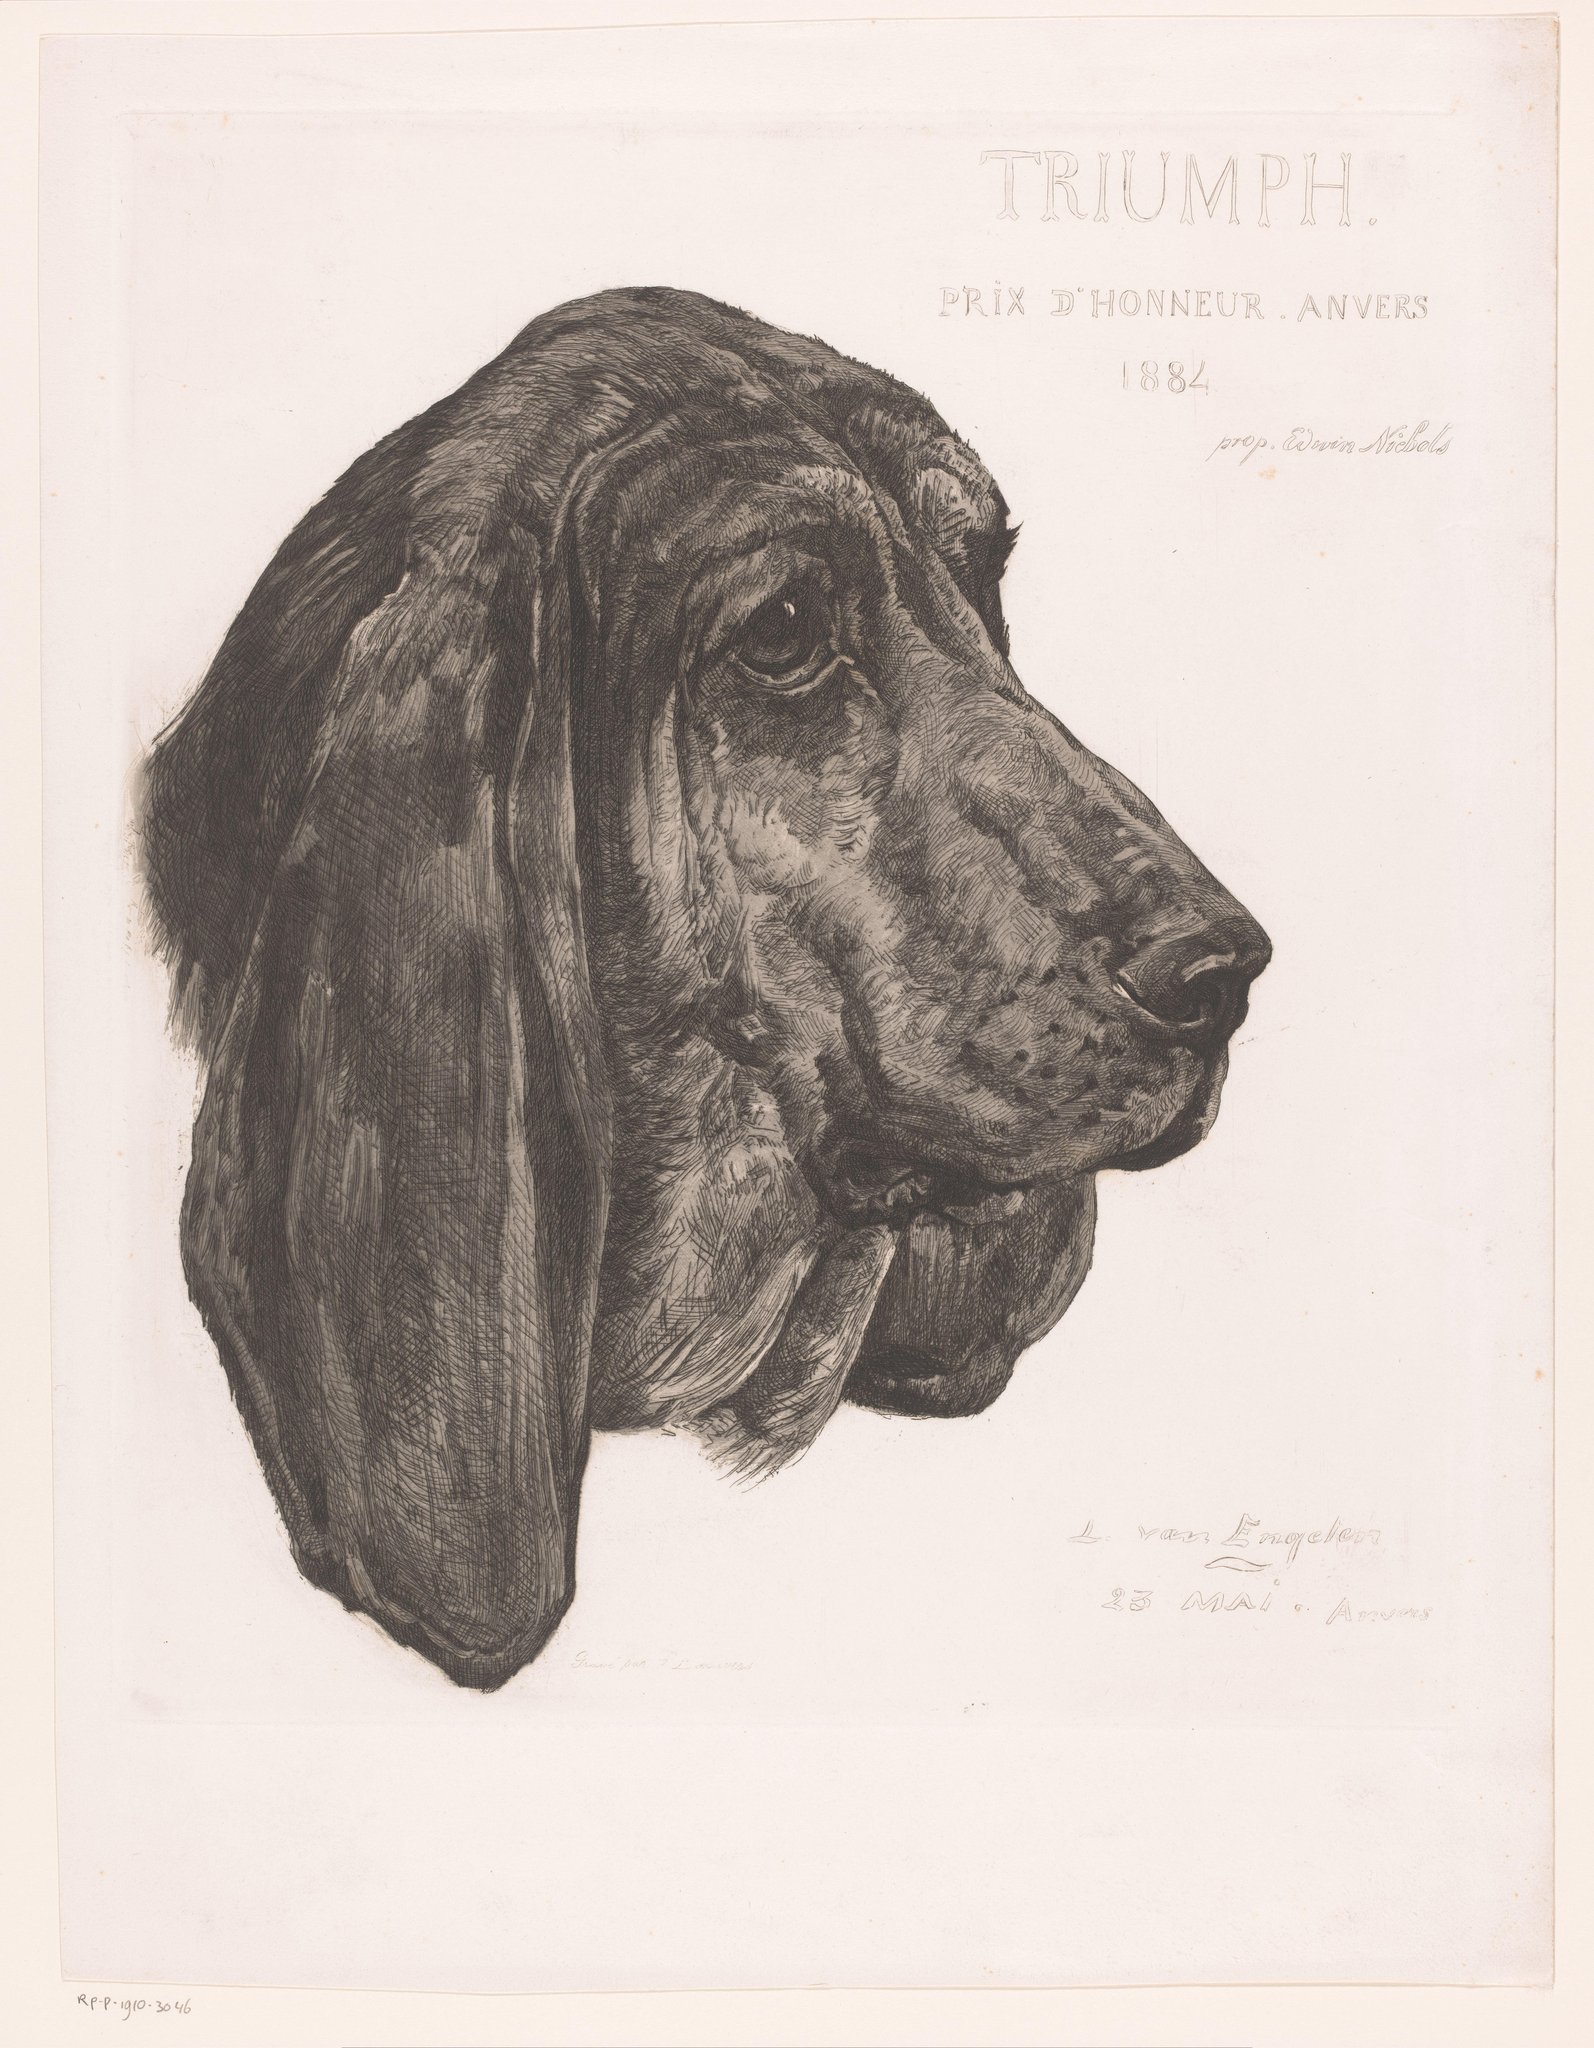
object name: print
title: Triumph. prix d'honneur. Anvers 1884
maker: louis van engelen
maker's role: print maker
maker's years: 1856-1940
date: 1884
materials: paper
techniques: etching, intaglio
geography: antwerp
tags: dog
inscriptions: collector's mark: Lugt 2228